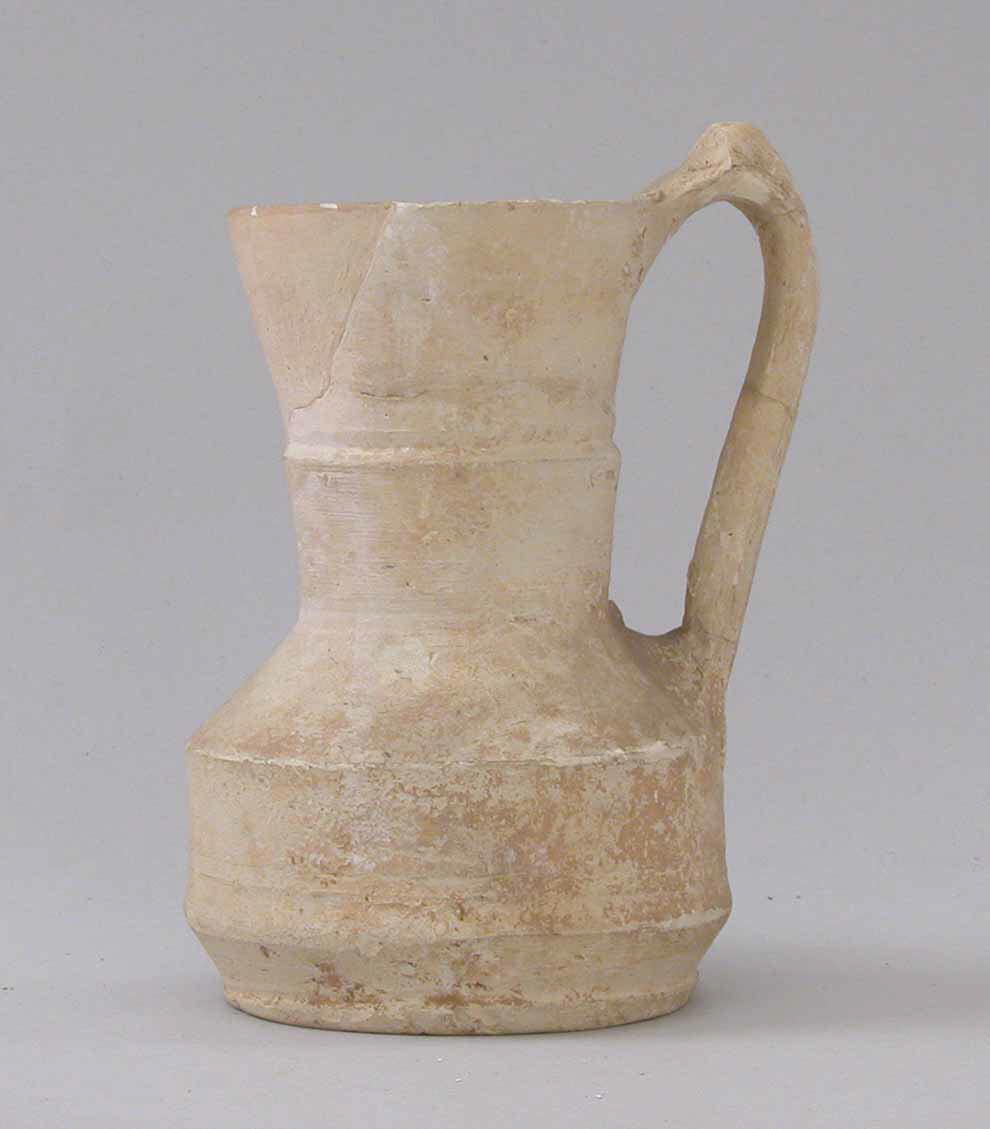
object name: jar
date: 801-1000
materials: earthenware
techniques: molding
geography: iraq